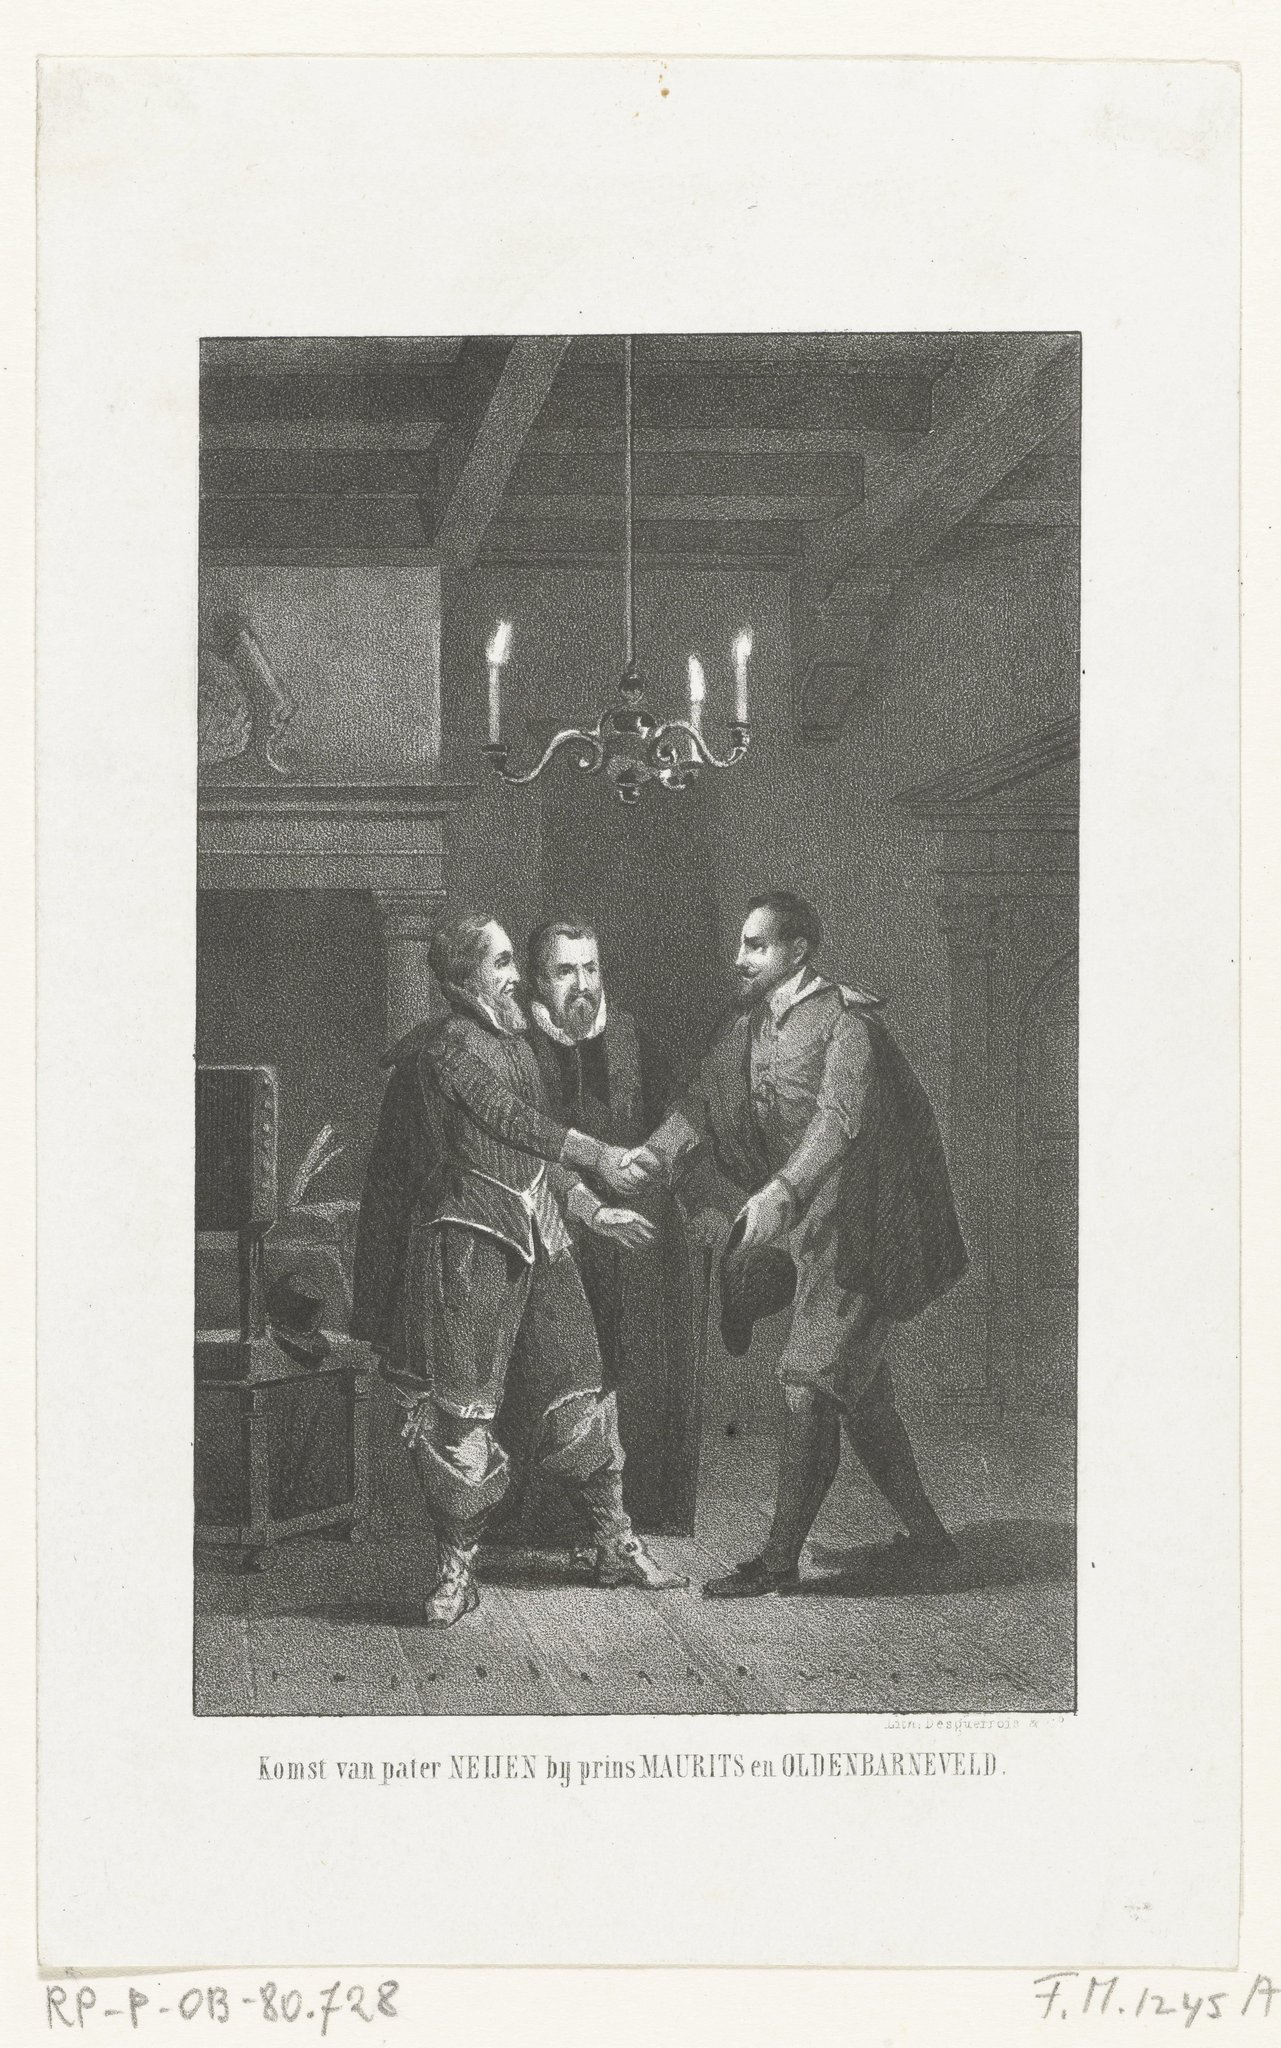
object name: print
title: Onderhandelingen over een bestand tussen pater Jan Neyen, prins Maurits en Johan van Oldenbarnevelt te Den Haag, 1607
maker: Anonymous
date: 1800-1899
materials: paper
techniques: lithograph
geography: netherlands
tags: johan van oldenbarnevelt, maurice (prince of orange), antwerp, spain, peace negotiations, the hague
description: De ontmoeting tussen pater Jan Neyen, prins Maurits en Johan van Oldenbarnevelt te Den Haag om te onderhandelen over een bestand, mei 1607. De pater en de prins schudden elkaar de hand in een interieur bij kaarslicht.